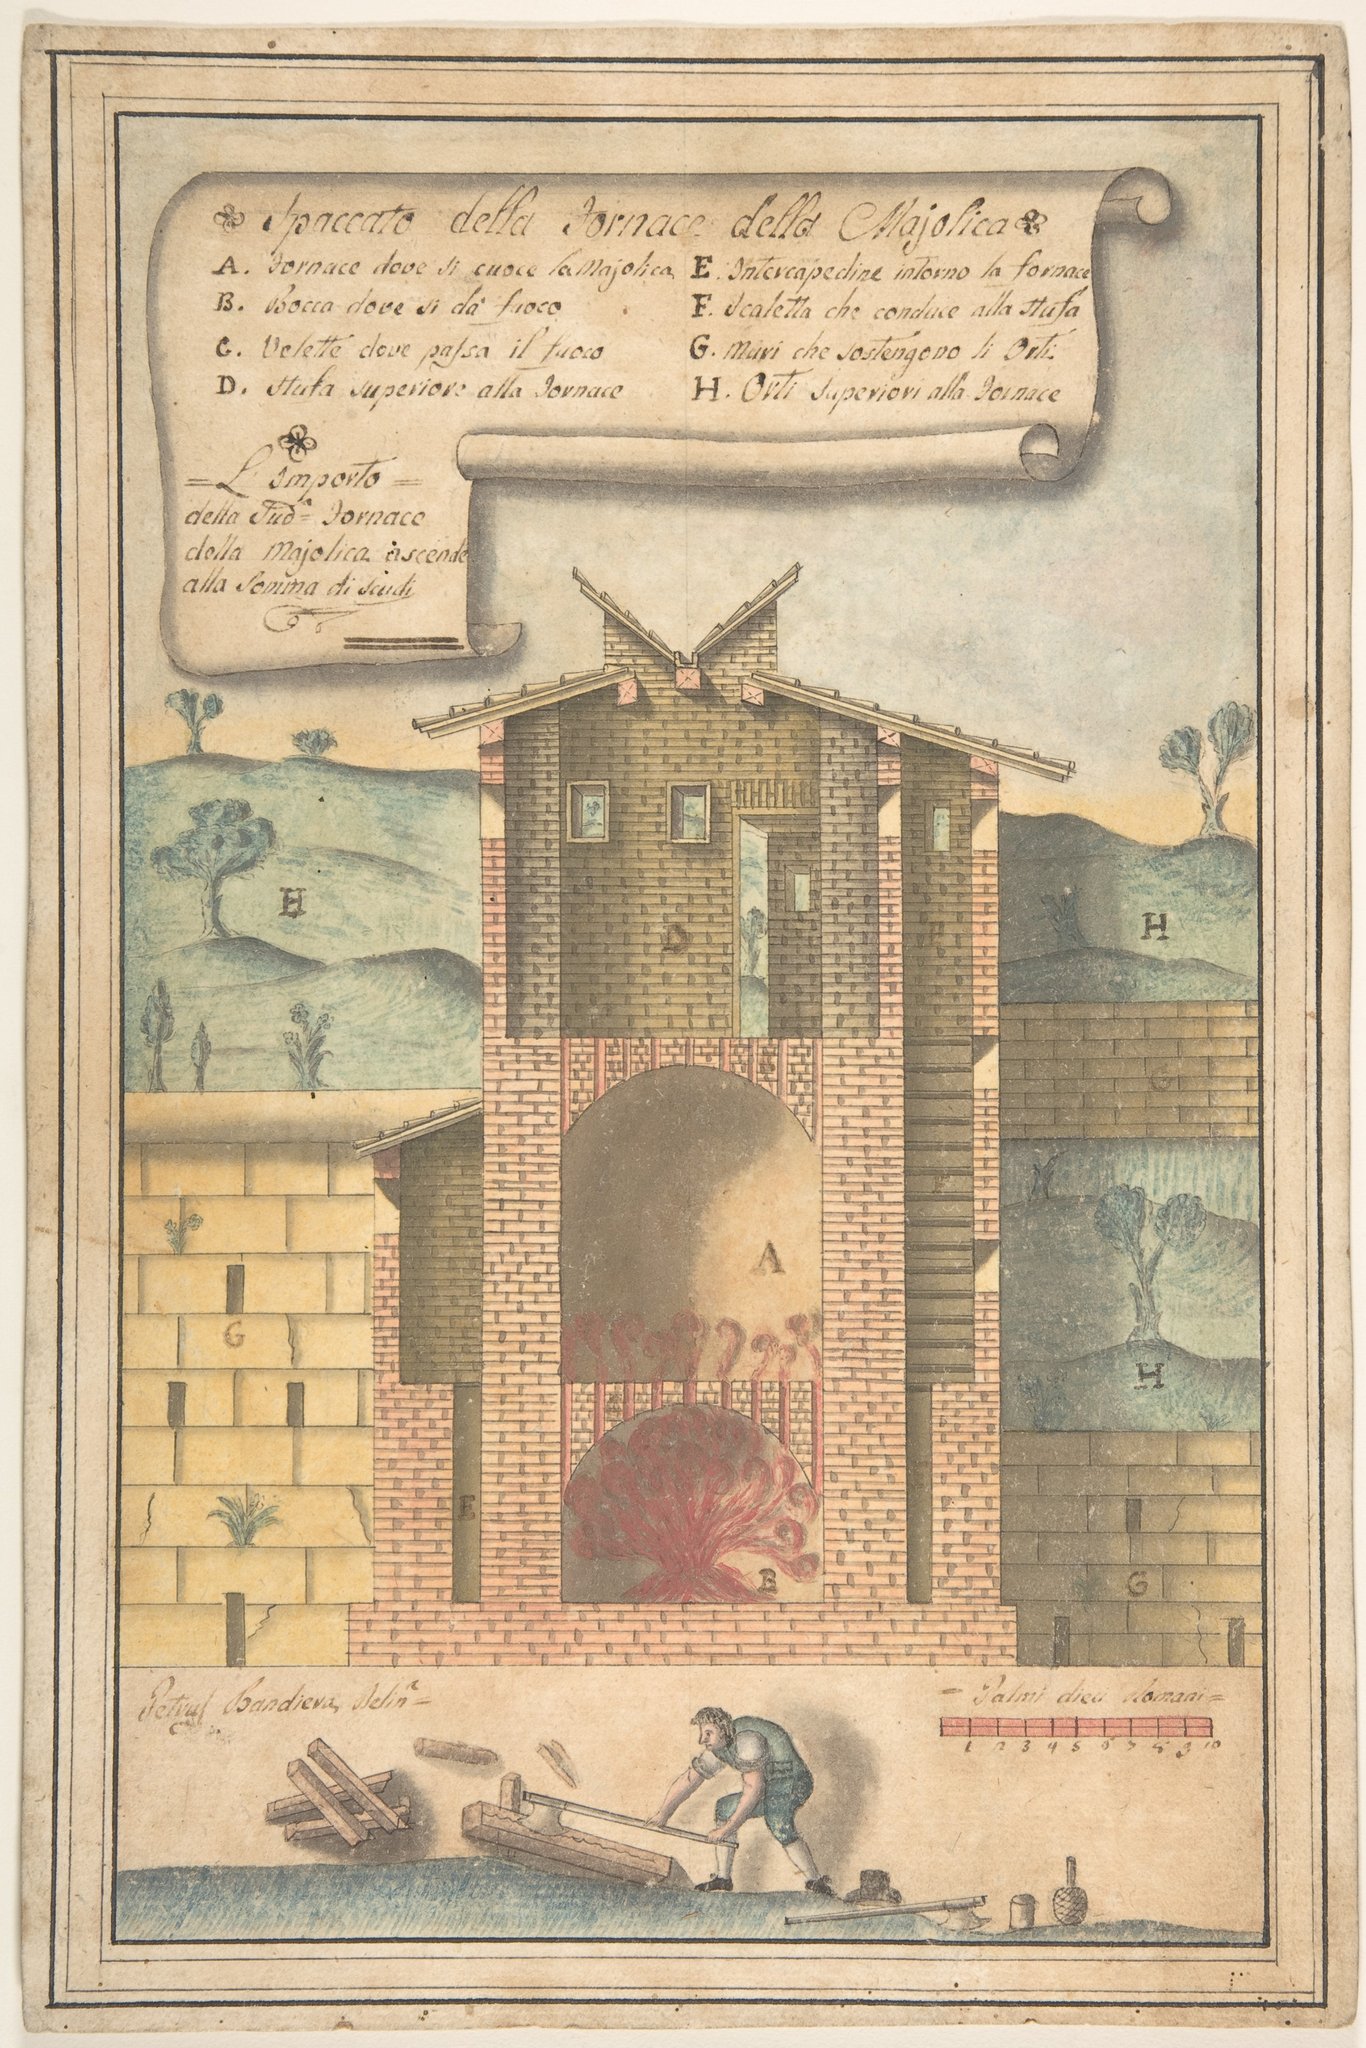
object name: ornament architecture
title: Section of a Kiln for the Production of Majolika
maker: pietro bandiera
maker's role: artist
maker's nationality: italian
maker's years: 1796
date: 1796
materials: ink, drawing material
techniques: pen, wash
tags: architecture,men,working